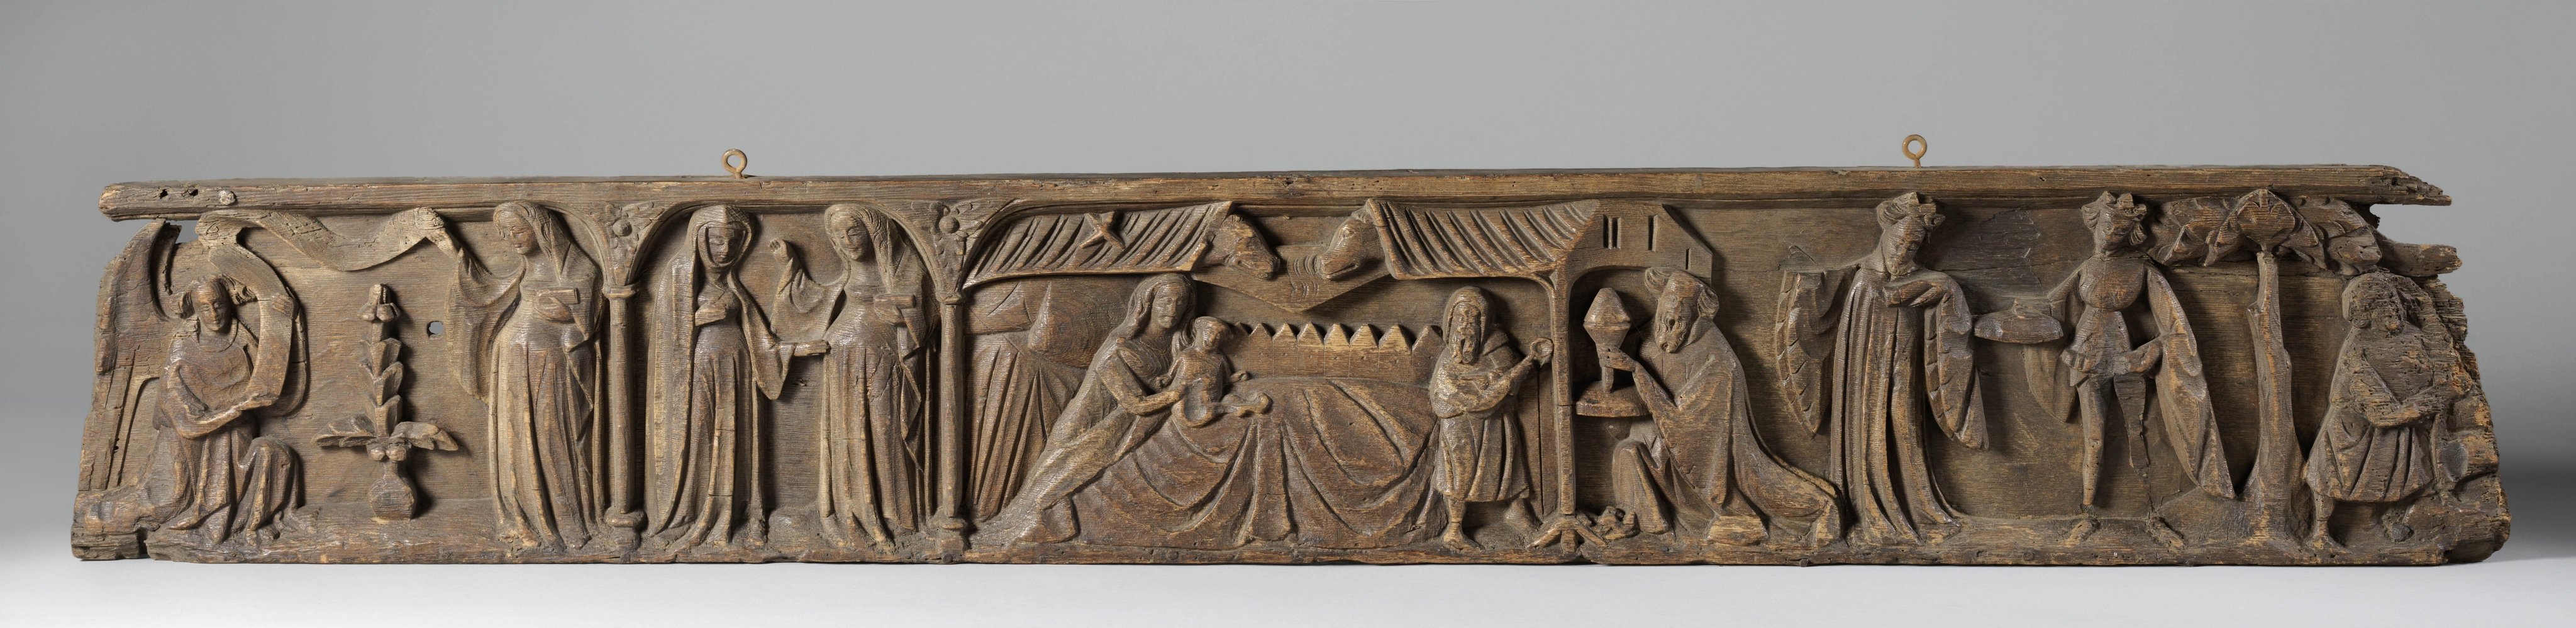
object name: relief sculpture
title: Relief with the Annunciation, the Visitation, the Nativity, the Adoration of the Magi and the Annunciation to the Shepherds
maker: Anonymous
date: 1390-1425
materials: wood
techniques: carving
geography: brabant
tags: annunciation of christ's birth to the shepherds (and/or shepherdesses) at night; a host of singing angels in the air, mary reclining in bed or on a couch, looking at the christ-child, the annunciation: mary standing, visitation (possibly joseph and/or zacharias present) (luke 1:39-56), adoration of the kings: the wise men present their gifts to the christ-child (gold, frankincense and myrrh)